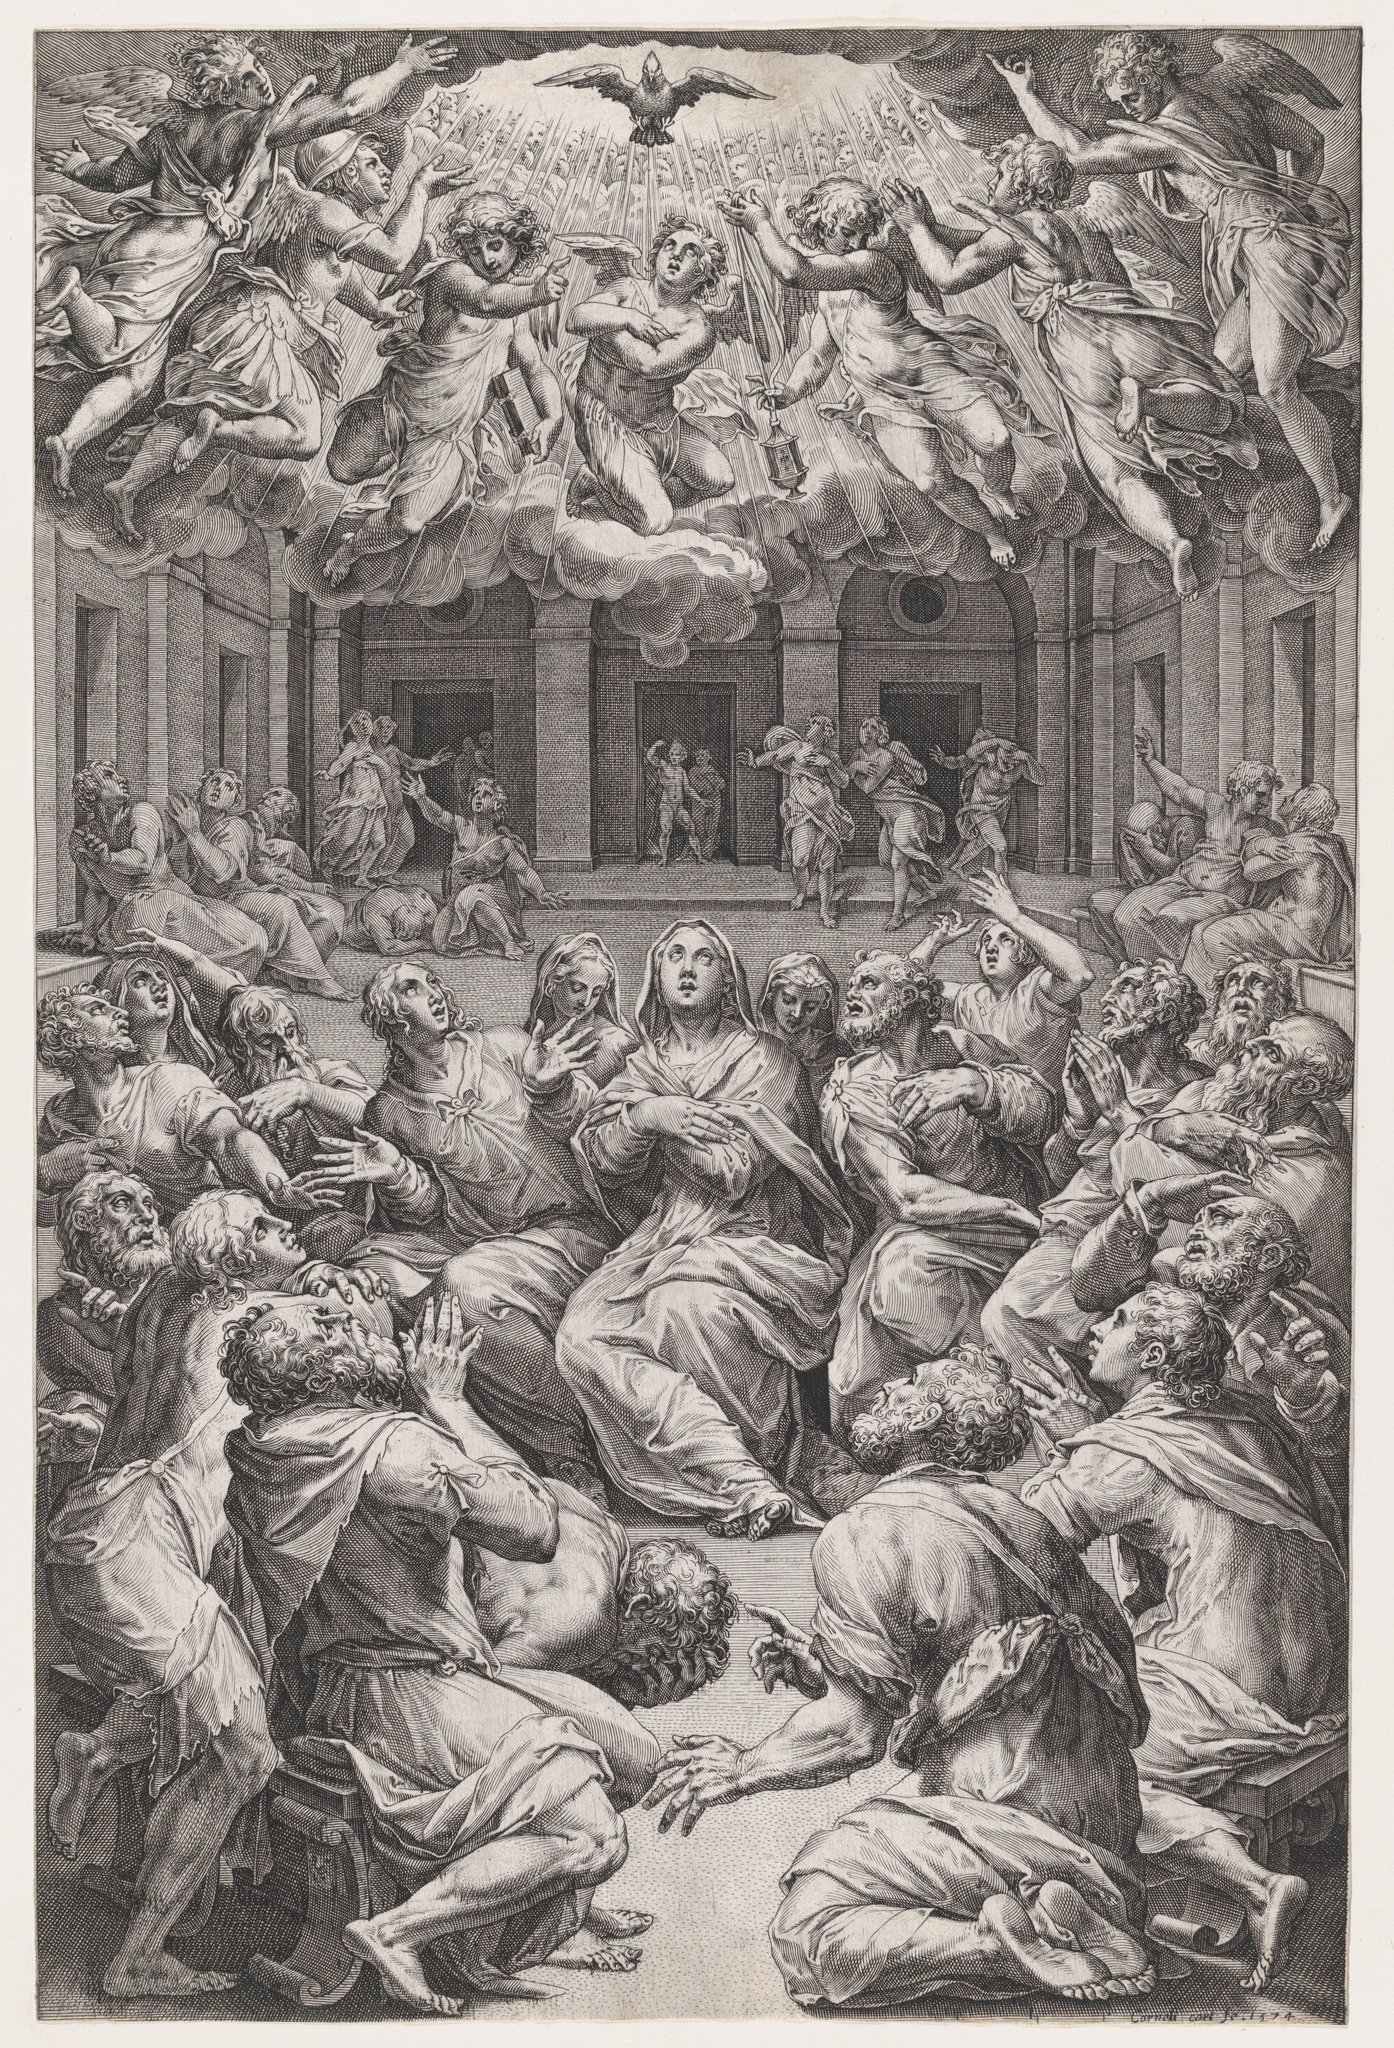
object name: print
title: The Pentecost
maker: cornelis cort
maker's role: artist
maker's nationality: netherlandish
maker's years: 1533-1578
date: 1574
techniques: engraving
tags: human figures,angels,apostles,christ